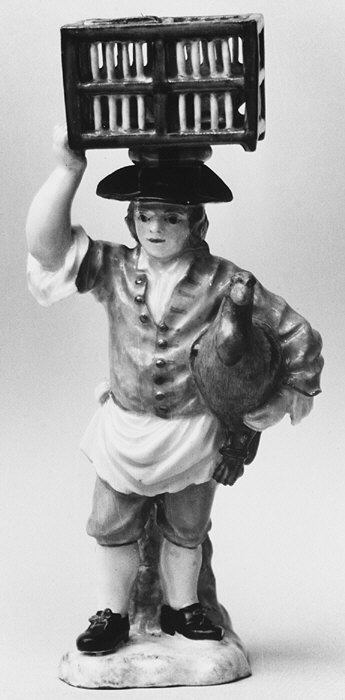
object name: figure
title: Bird Vendor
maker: zurich pottery and porcelain factory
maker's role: factory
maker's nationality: swiss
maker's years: 1763-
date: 1773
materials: hard paste porcelain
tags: birds,men